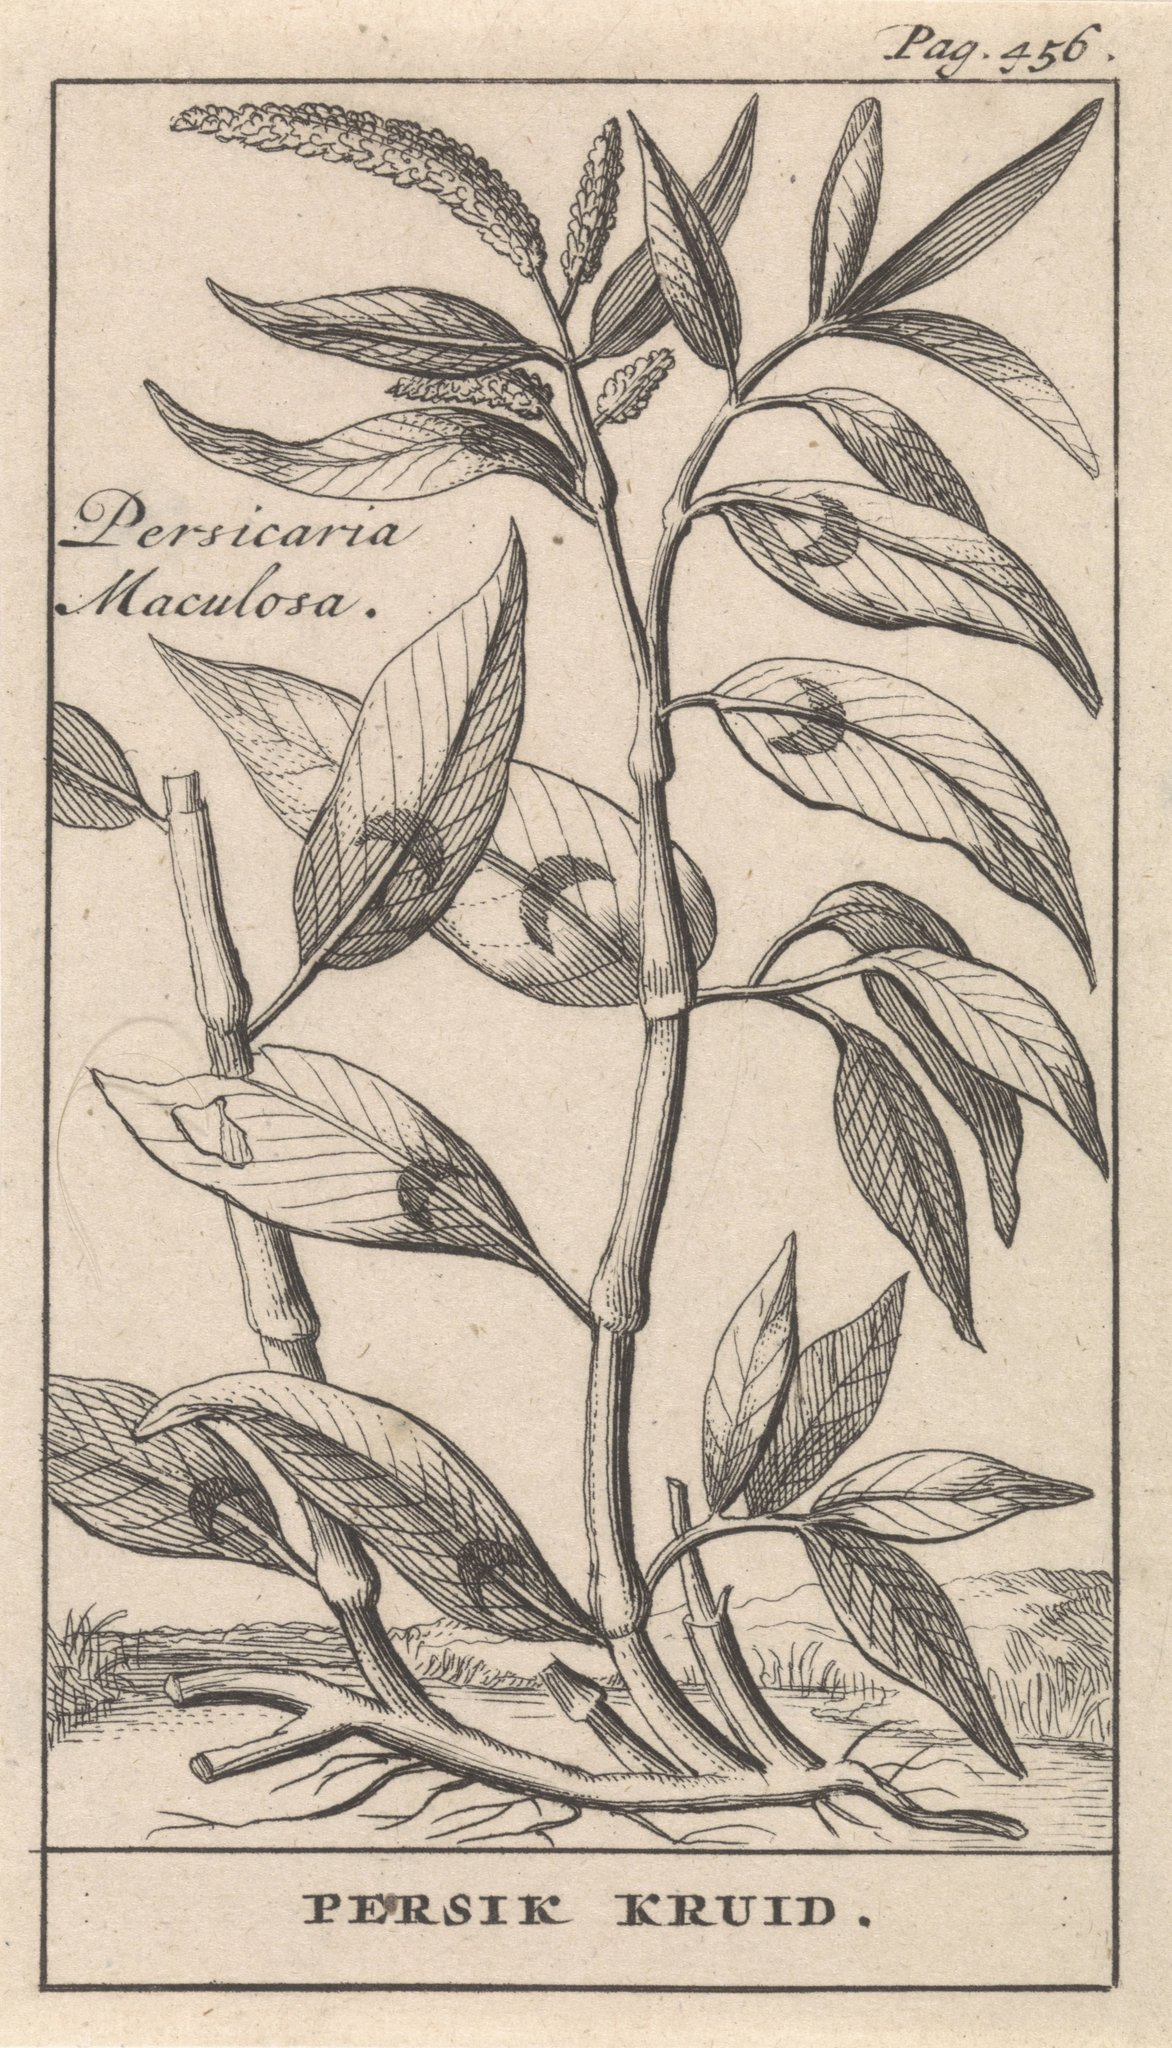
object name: book illustration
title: Perzikkruid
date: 1698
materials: paper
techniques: etching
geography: amsterdam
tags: plants and herbs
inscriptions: collector's mark: Lugt 2228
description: Illustratie uit: Blankaart, Steven. Den Neder-landschen herbarius ofte Kruid-boek der voornaamste kruiden. Amsterdam: Jan Claesz ten Hoorn, 1698.